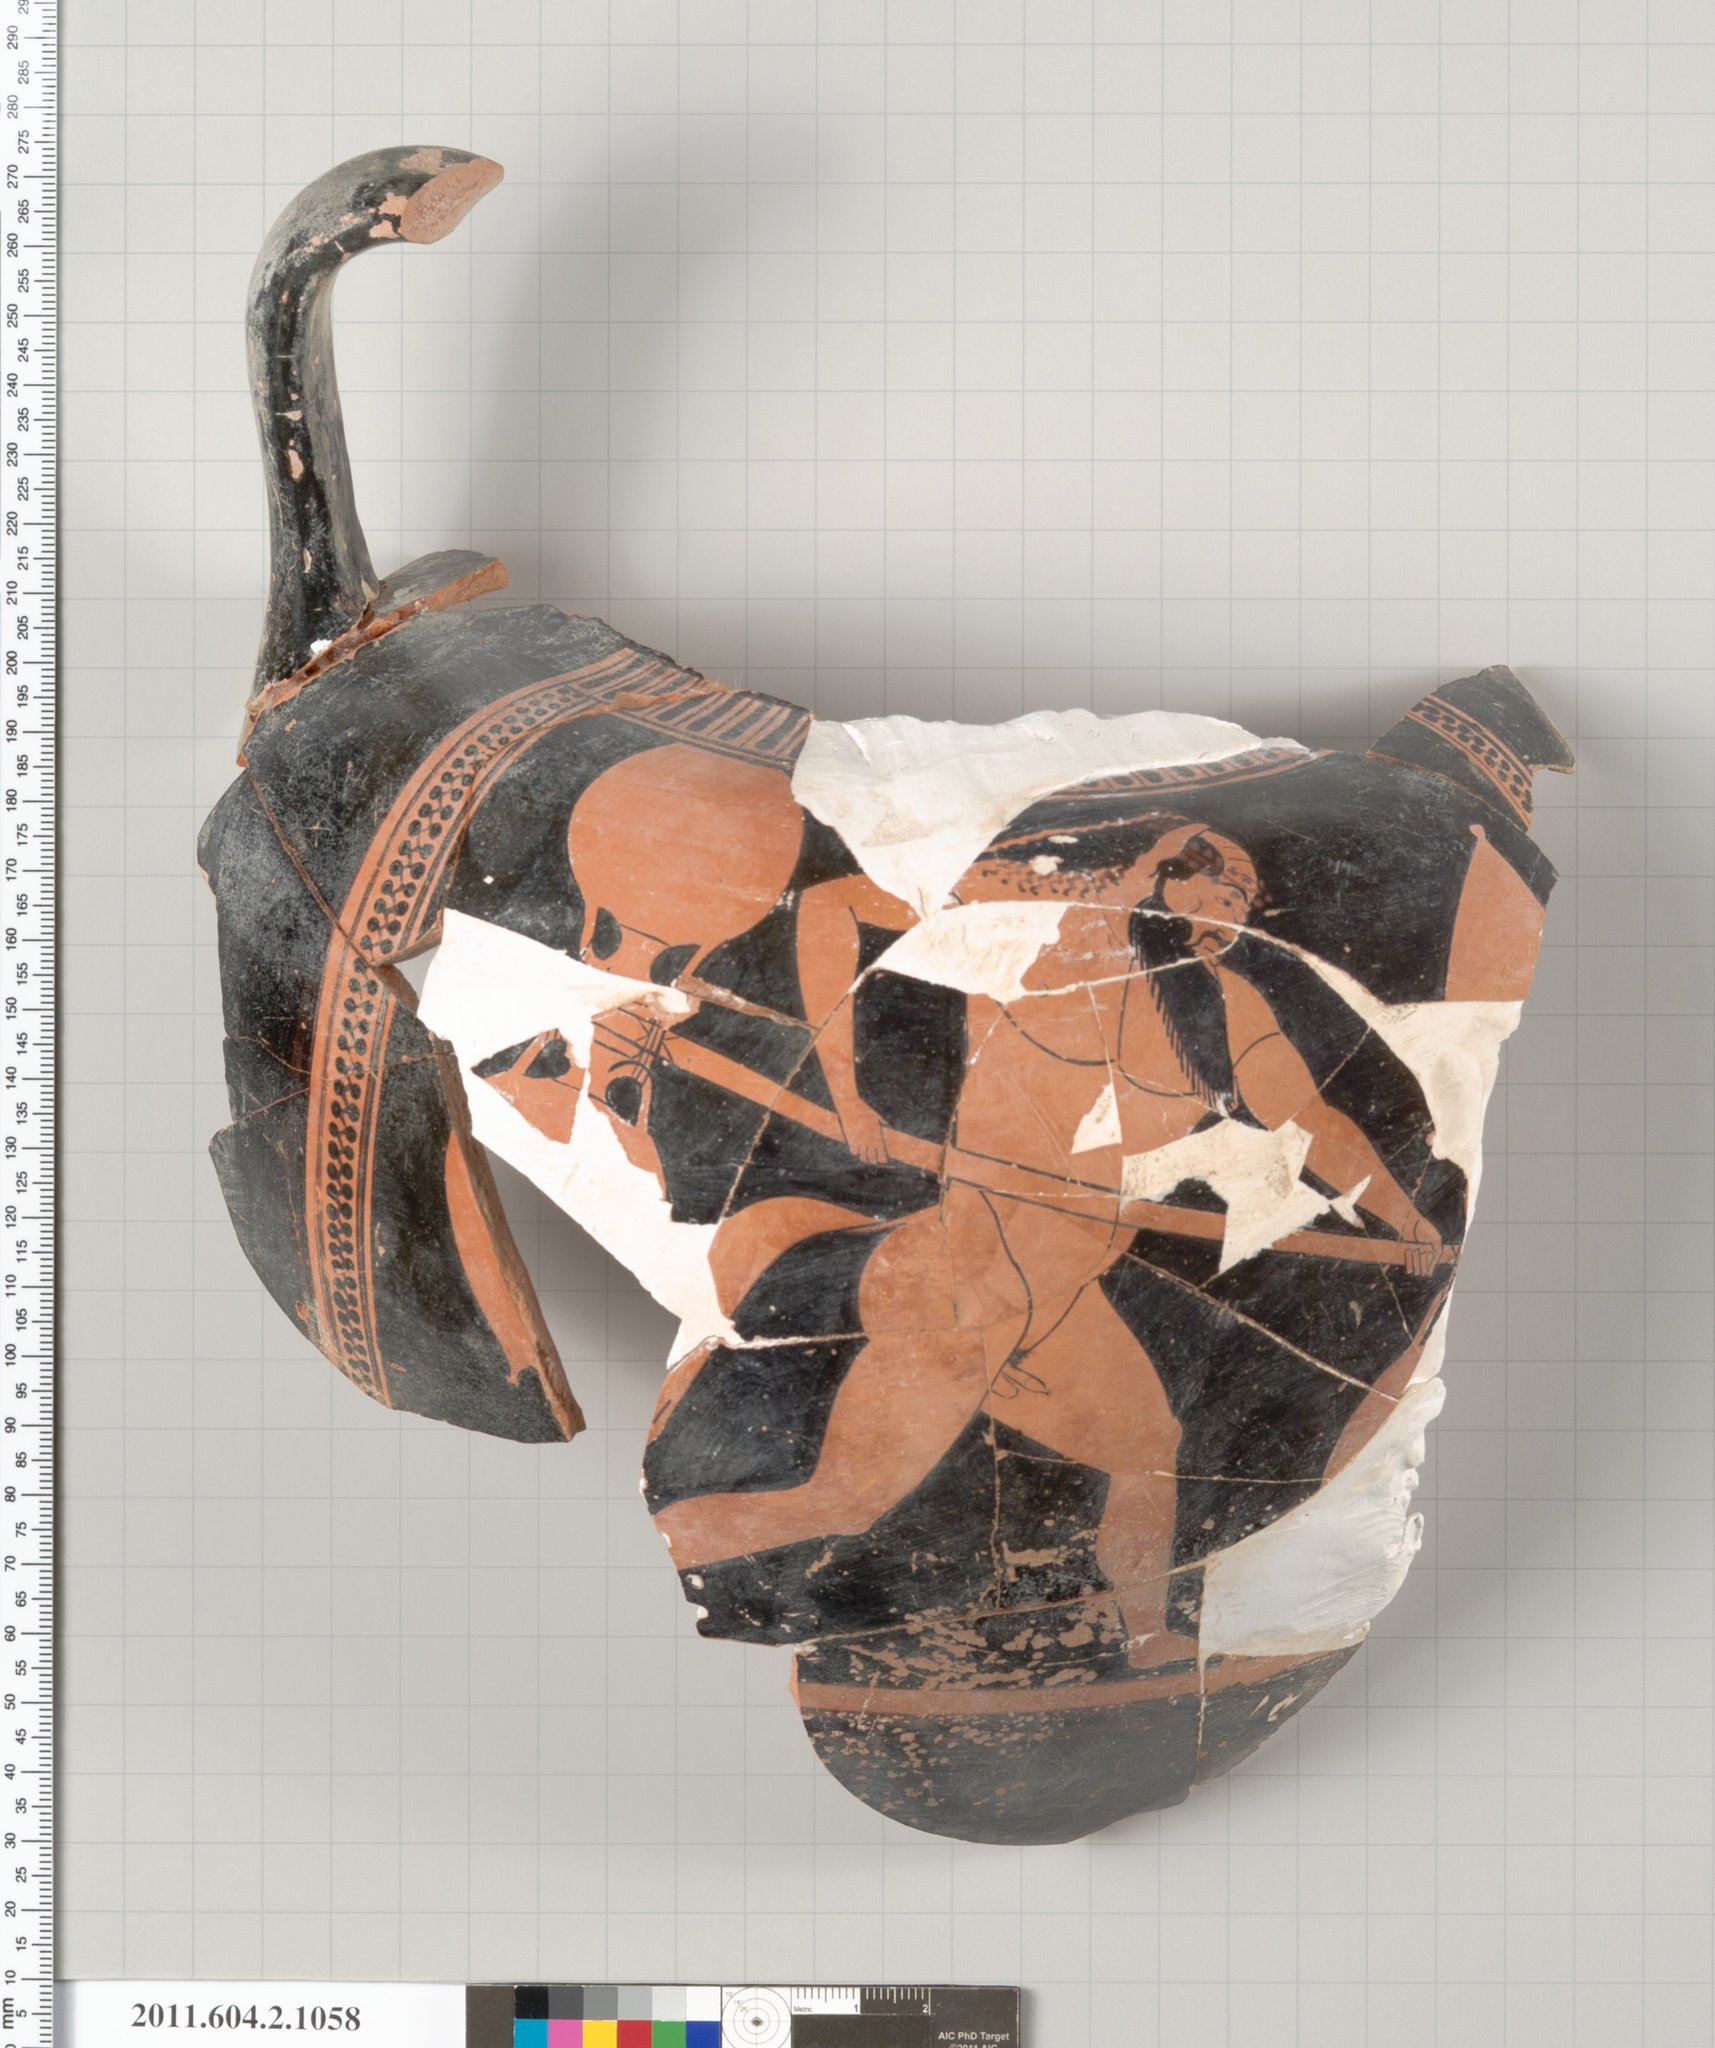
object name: pelike fragment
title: Terracotta fragment of a pelike (jar)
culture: greek, attic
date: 500-476 BCE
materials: terracotta